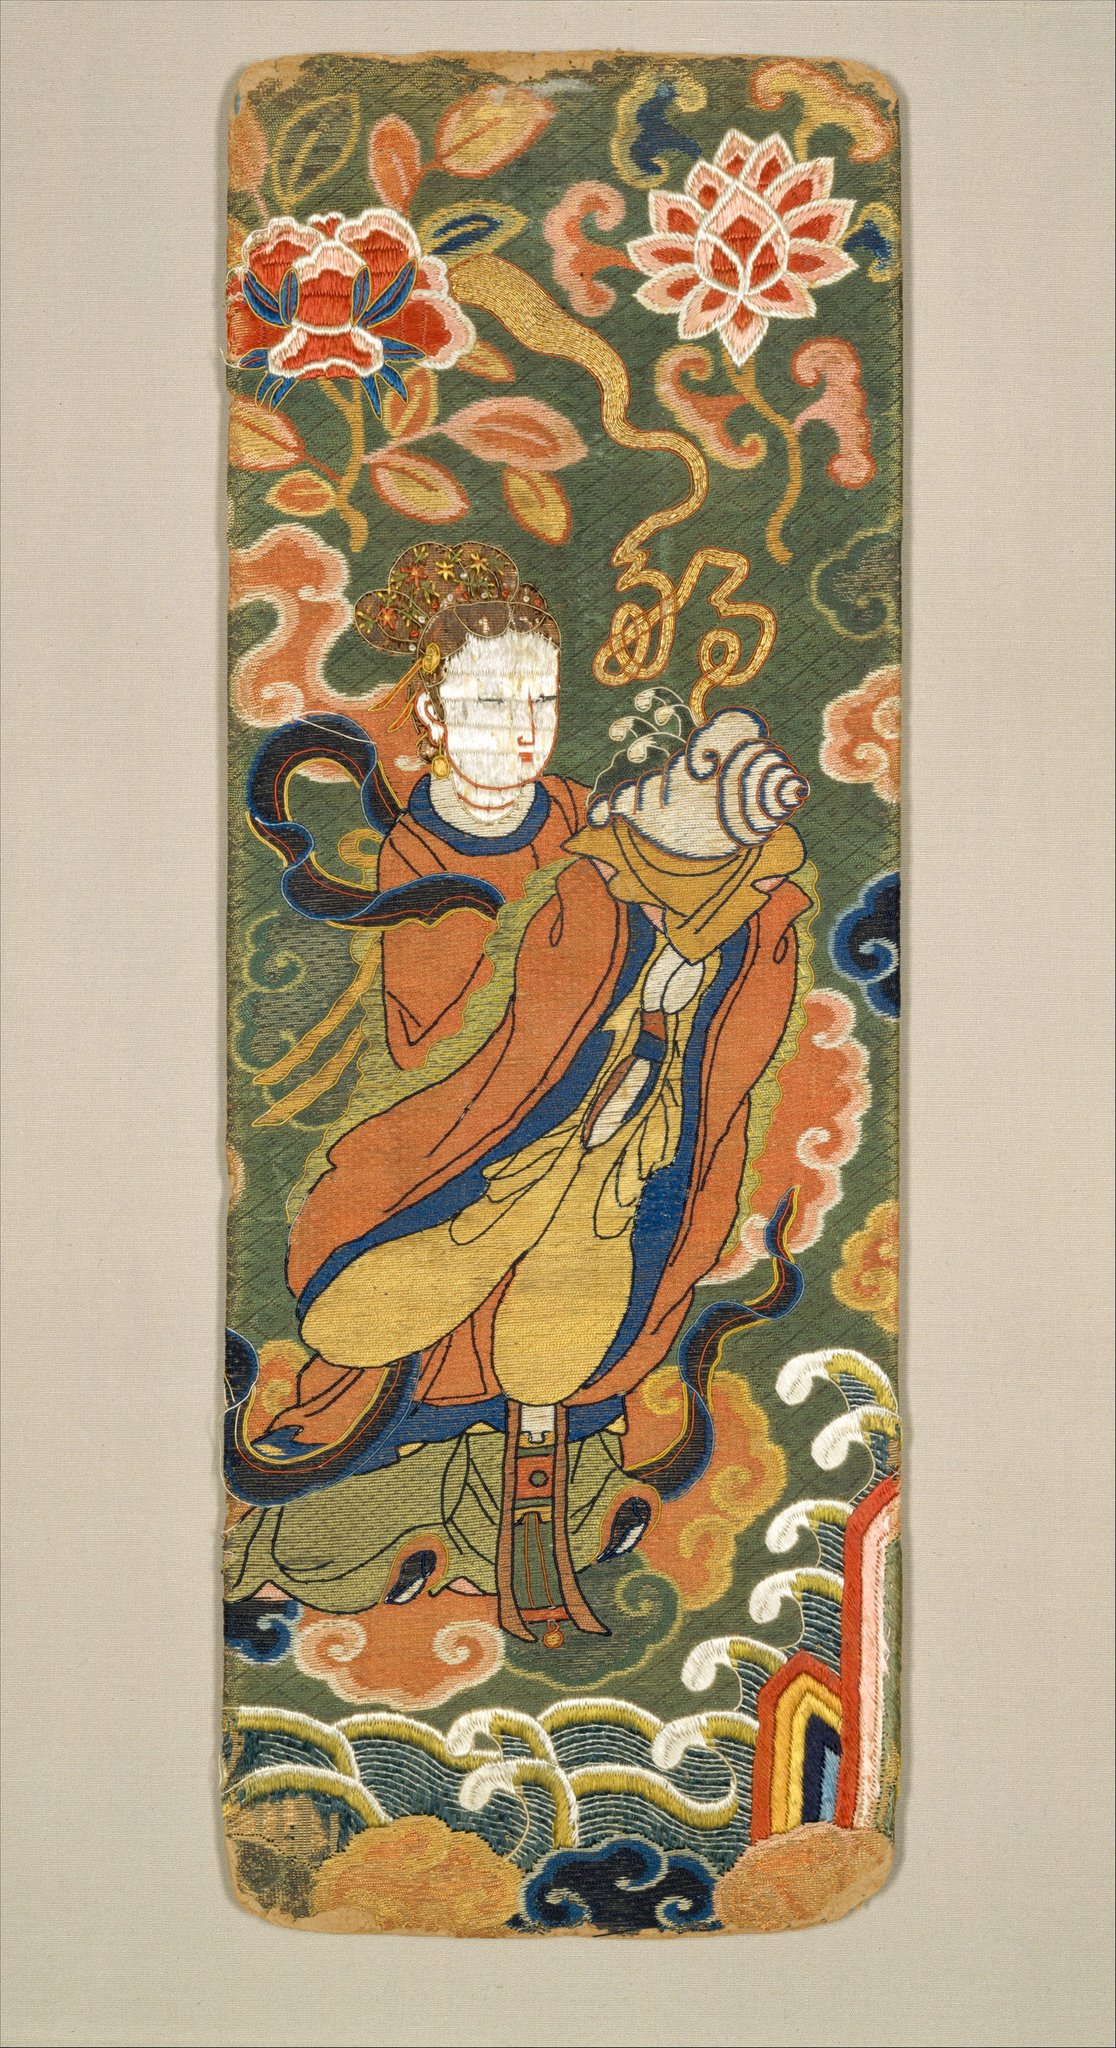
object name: book or sutra cover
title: Book or Sutra Cover with Lady Bearing a Conch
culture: chinese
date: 1501-1600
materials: silk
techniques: patterning, weave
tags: women,flowers,shells